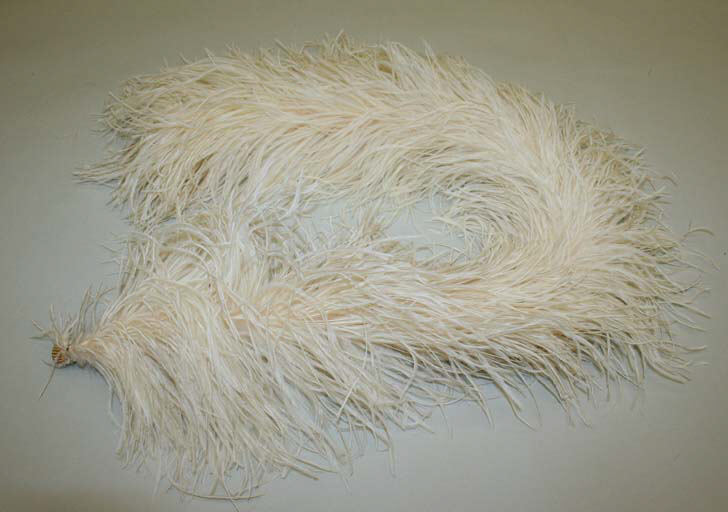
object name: boa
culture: american or european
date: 1700-1944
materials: feather